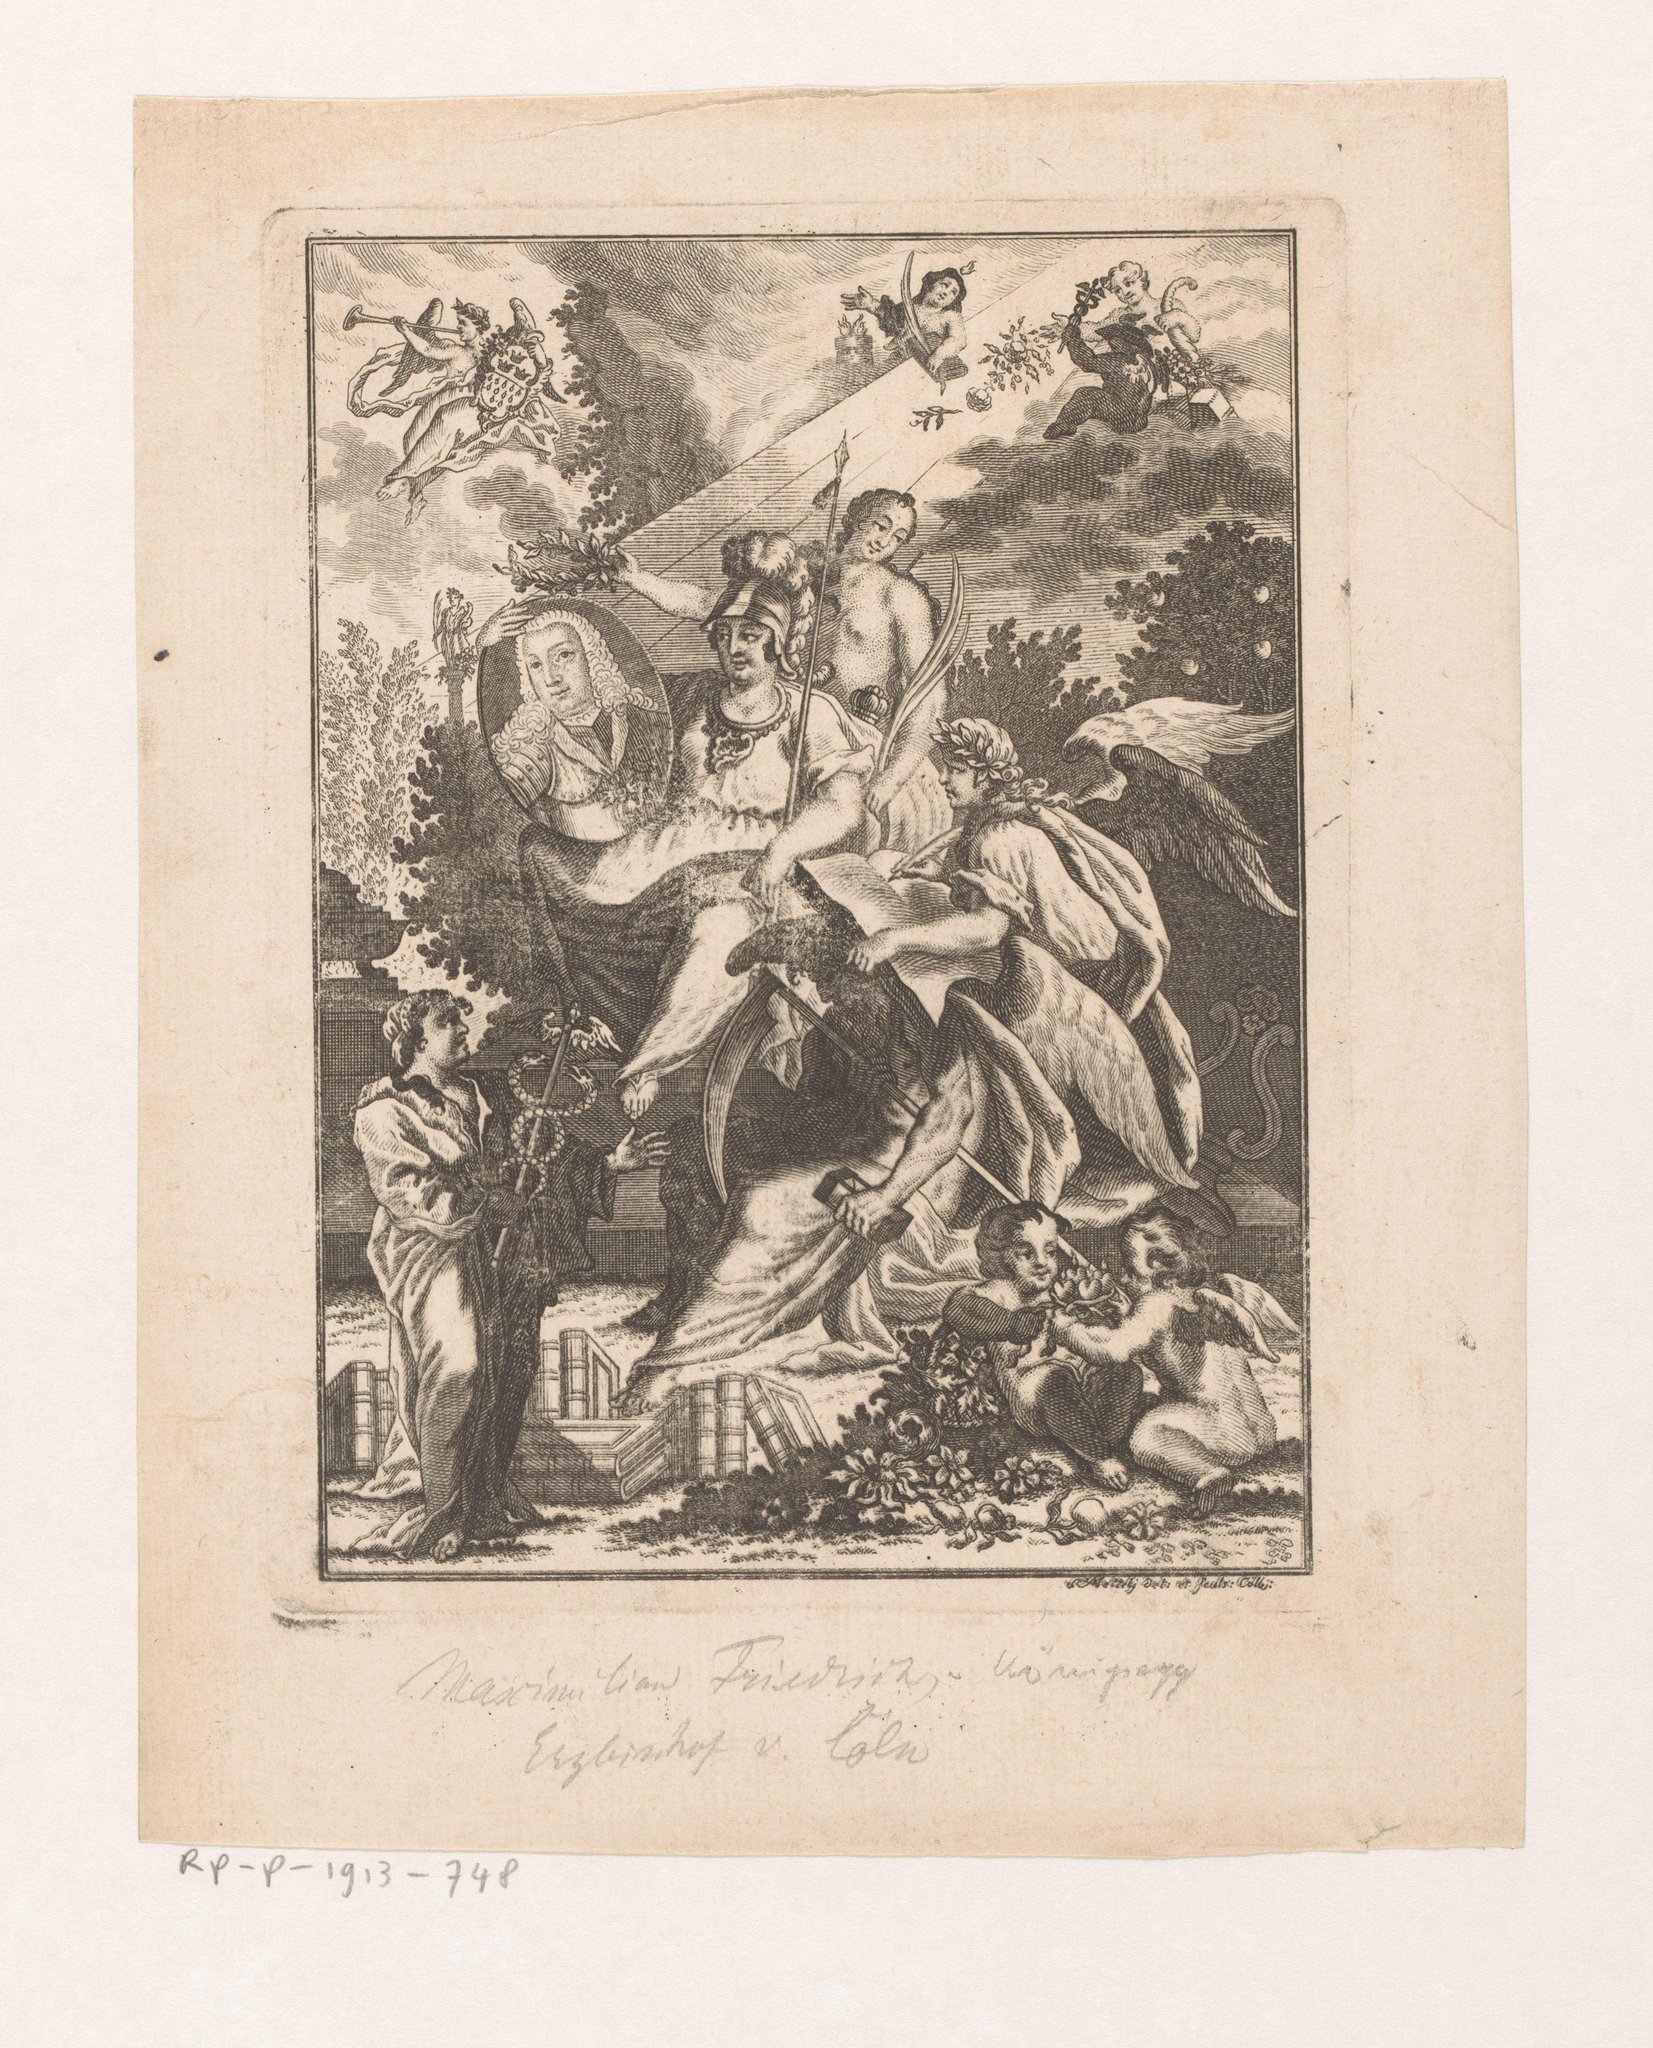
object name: print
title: Portret van Maximilian Friedrich Reichsgraf von Königseck-Rothenfels, met allegorie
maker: nicolaus mettel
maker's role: print maker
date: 1739-1778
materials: paper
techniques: etching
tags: garland, wreath, historical persons, book, allegory of time and eternity, cupids: 'amores', 'amoretti', 'putti', armorial bearing, heraldry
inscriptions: collector's mark: Lugt 2228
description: De allegorie verbeeldt door middel van personificaties de oneindigheid van de godgegeven roem van de geportretteerde.